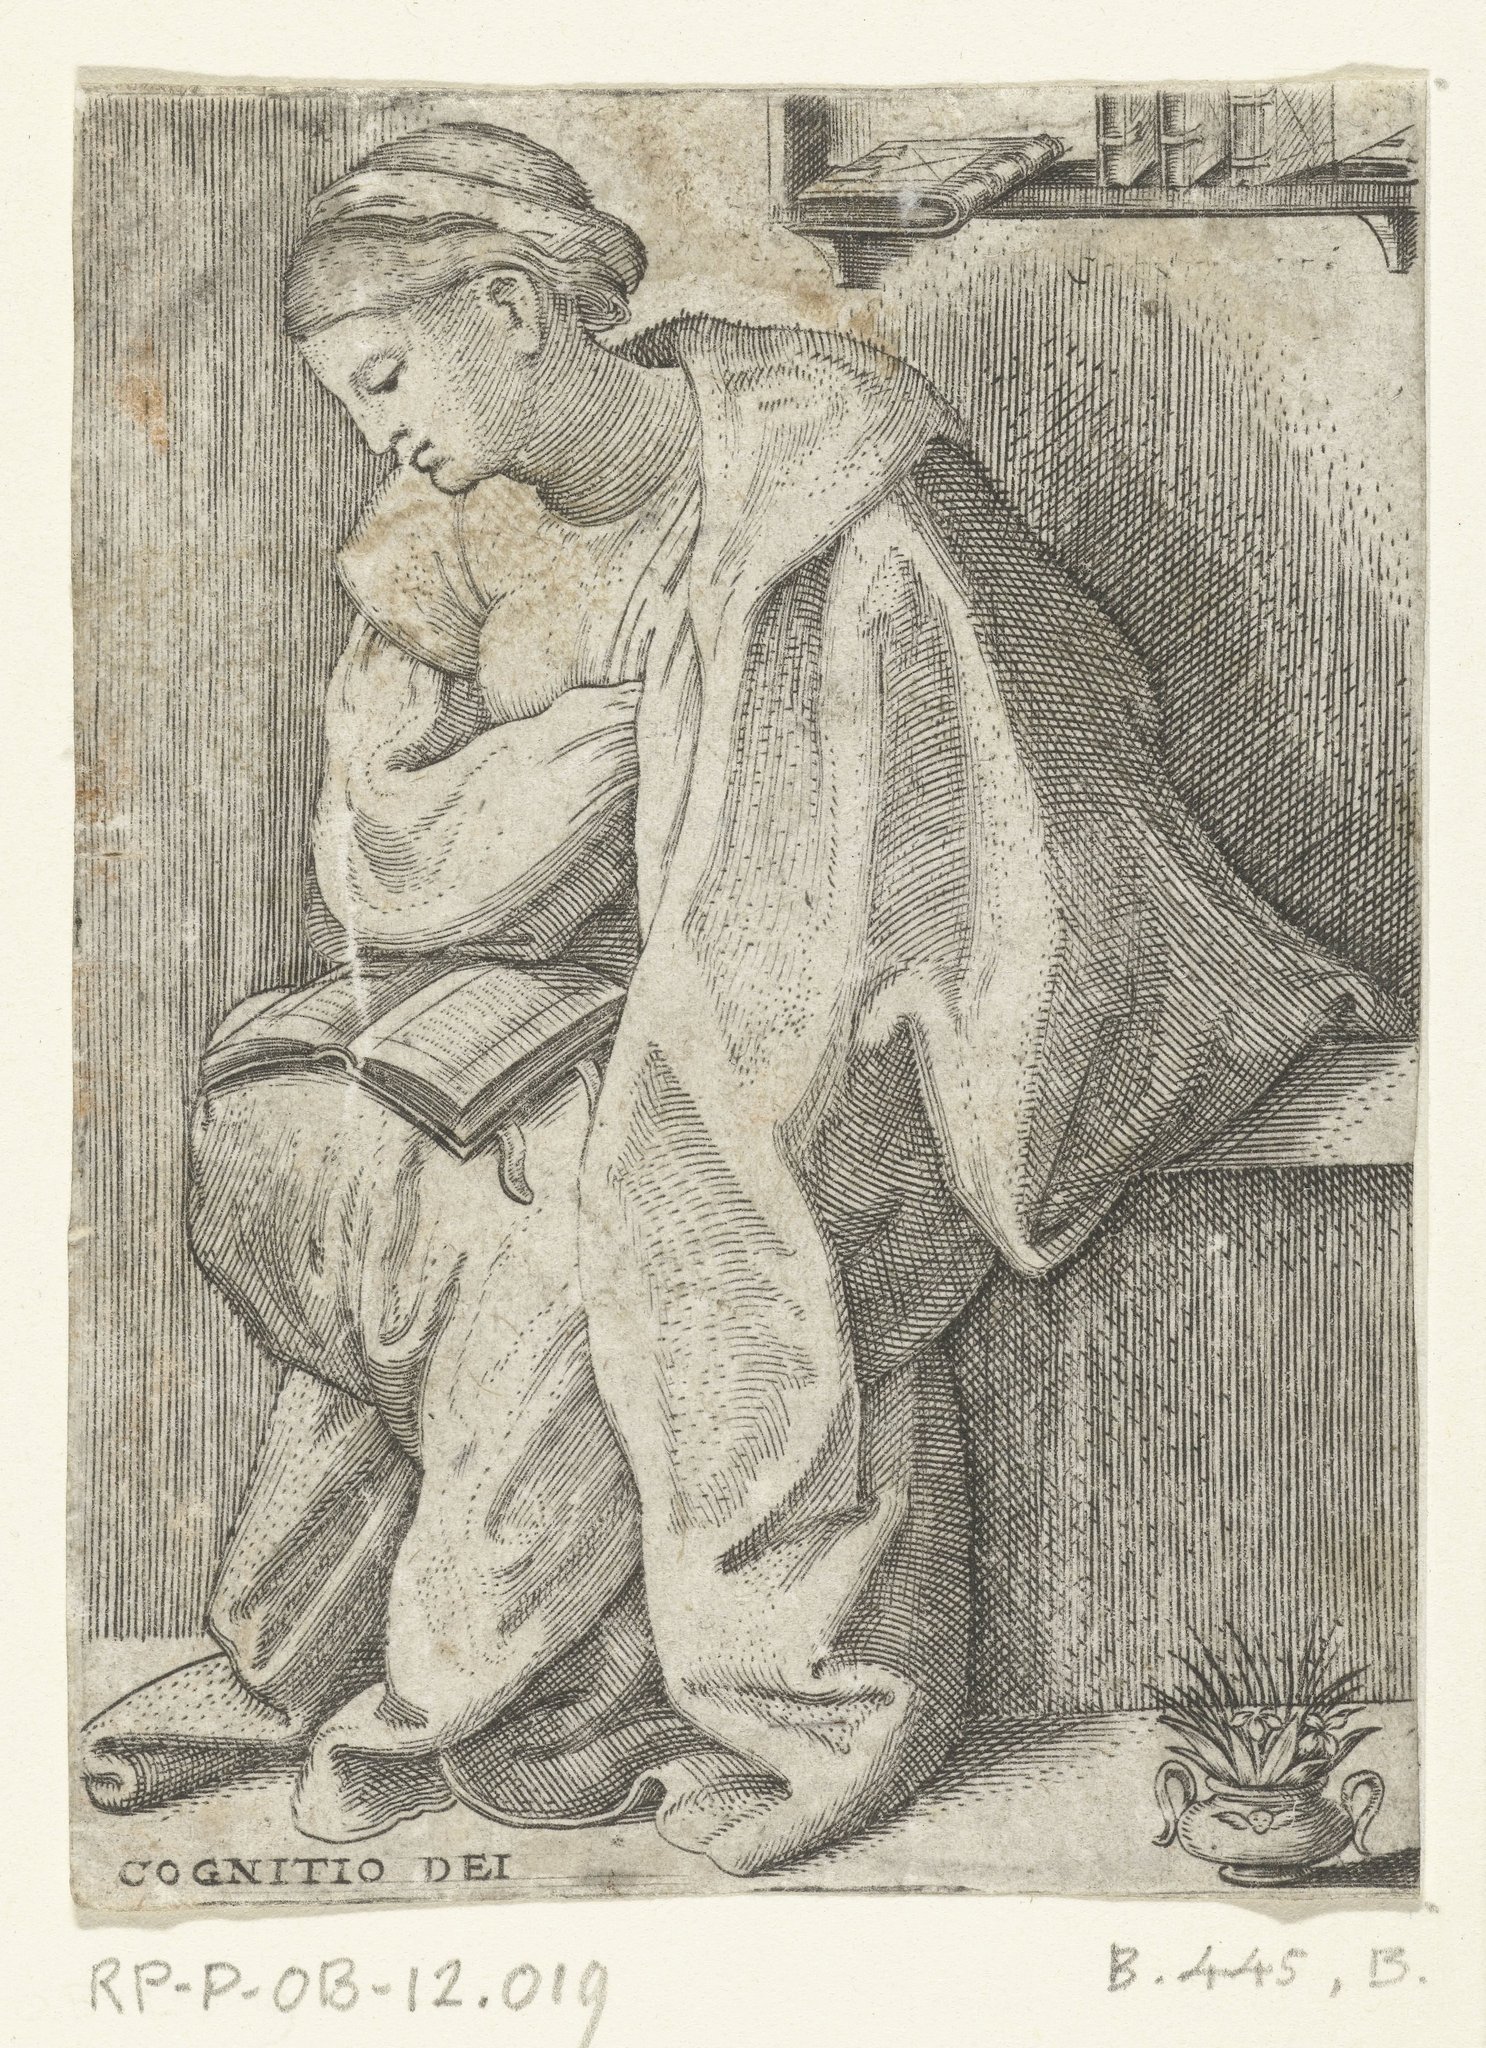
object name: print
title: Cognitio Dei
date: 1510-1575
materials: paper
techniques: engraving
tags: the (nude) human figure; 'corpo humano' (ripa) (+ thinking, meditating)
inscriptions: collector's mark: Lugt 240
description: Kopie in spiegelbeeld naar prent van Marcantonio Raimondi. Raimondi baseerde zich mogelijk op een ontwerp van Raphael.